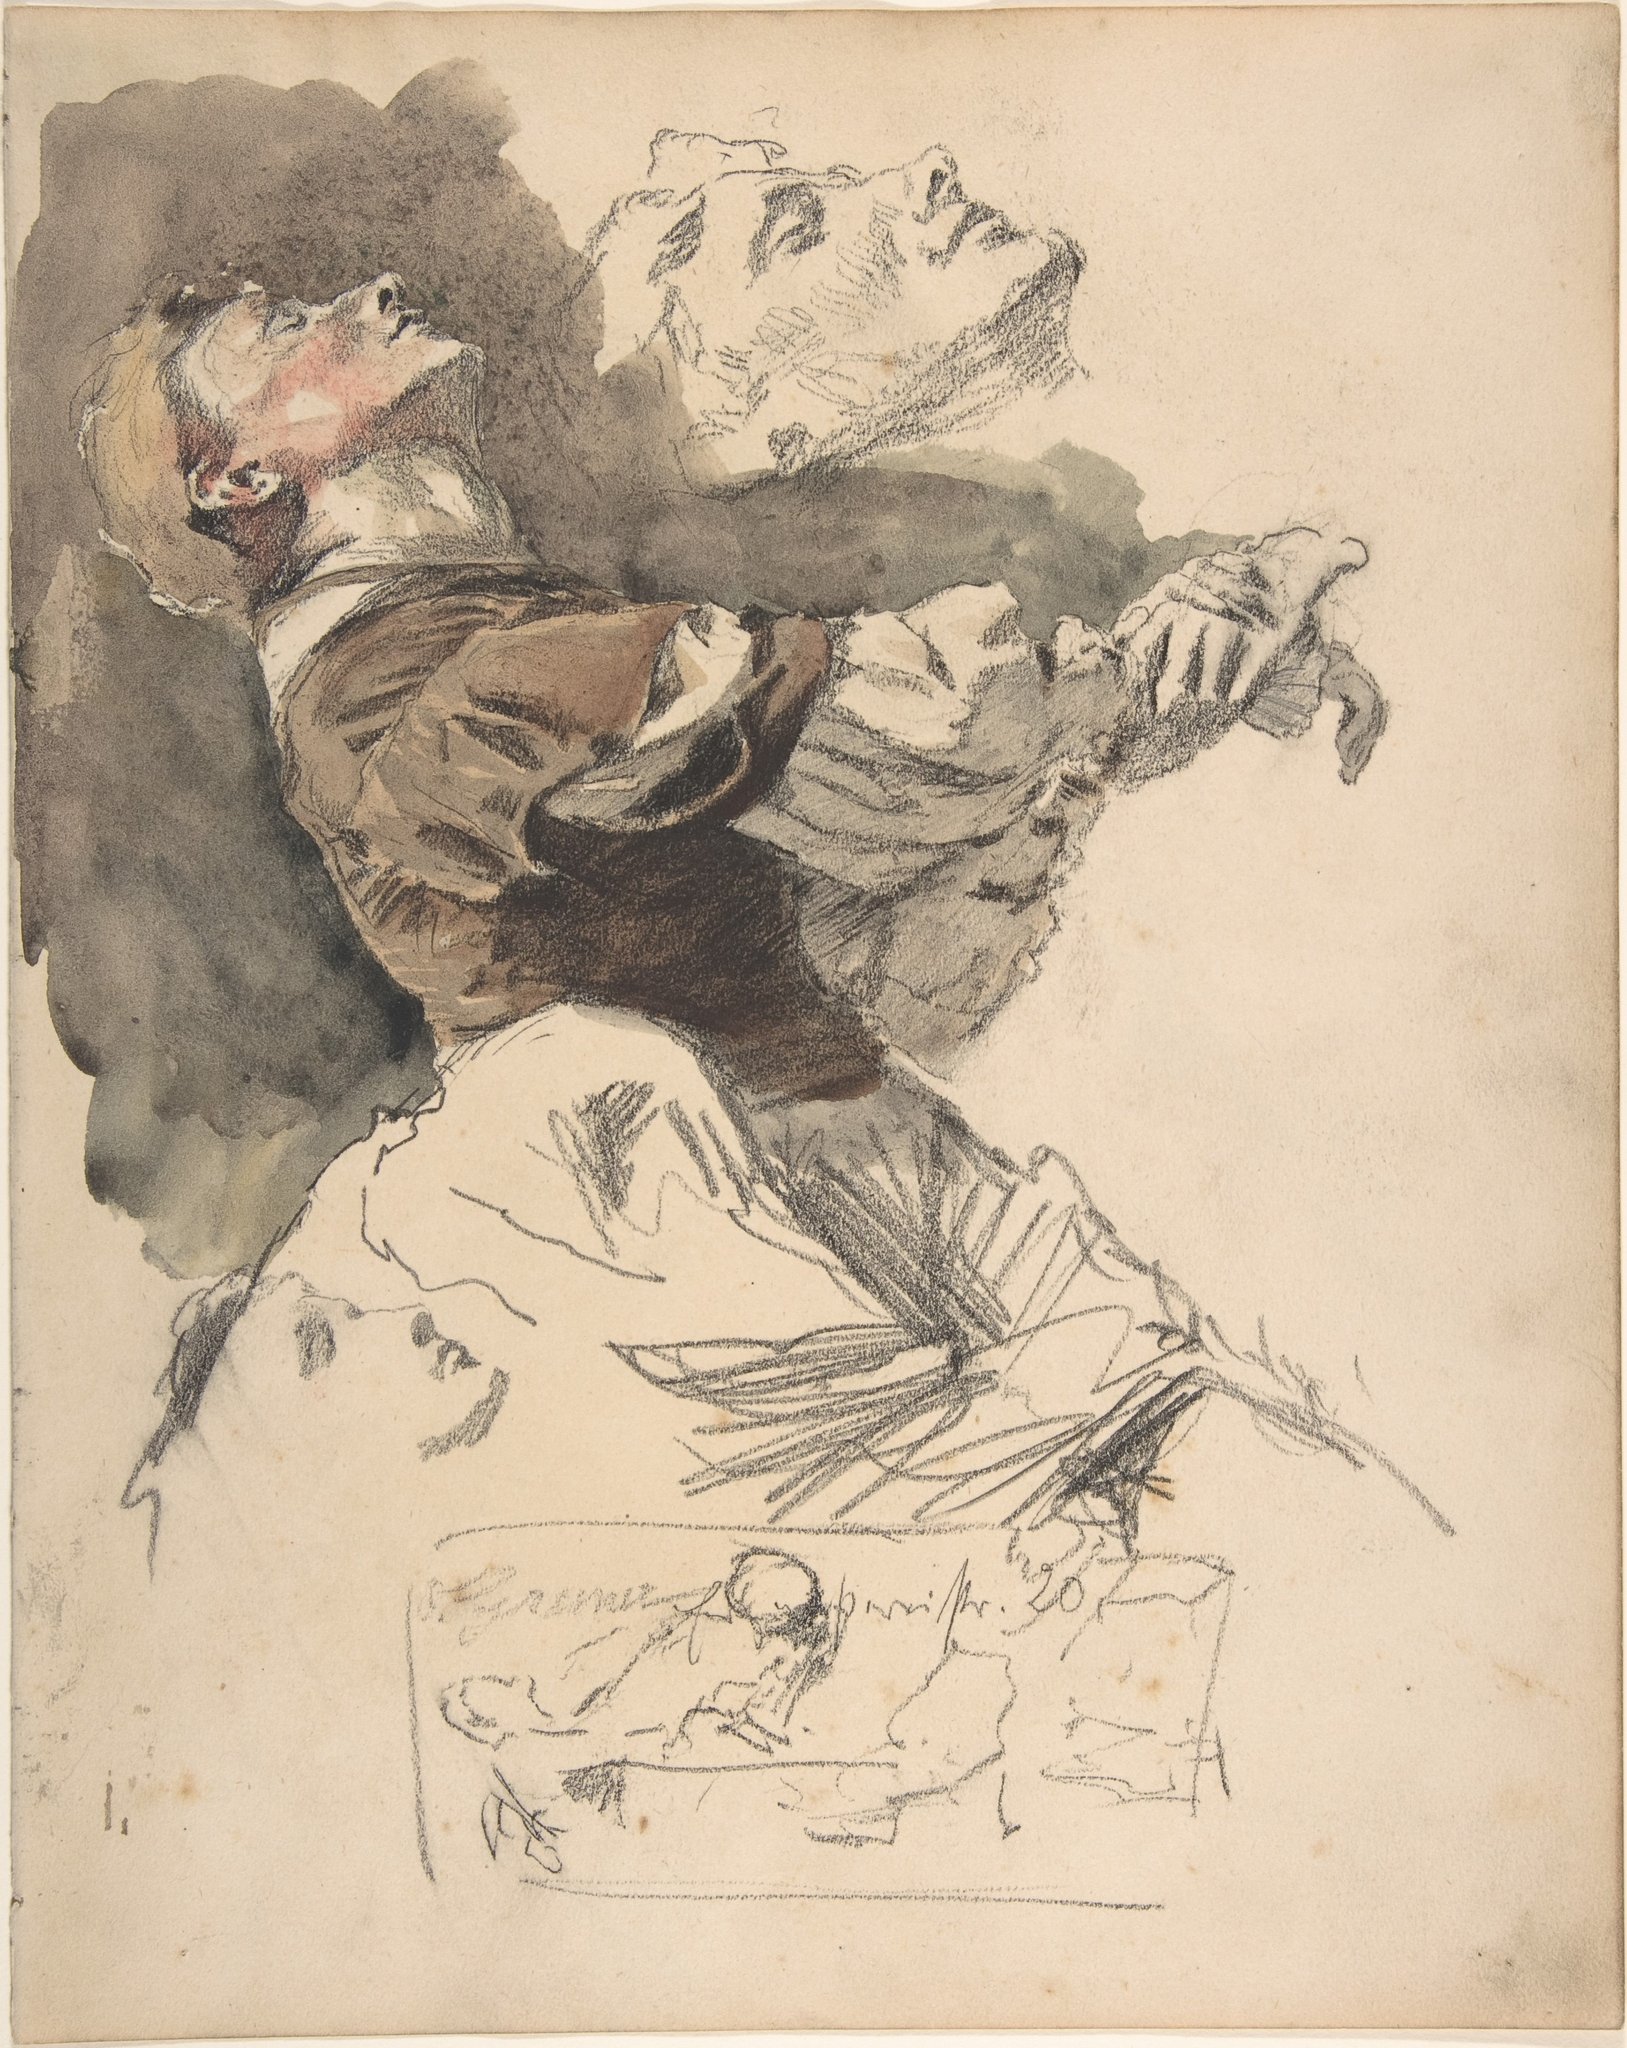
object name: drawing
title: Study of a Female Dancer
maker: otto greiner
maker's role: artist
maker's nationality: german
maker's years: 1869-1916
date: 1867-1933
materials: chalk, gouache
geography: germany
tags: women,dancers